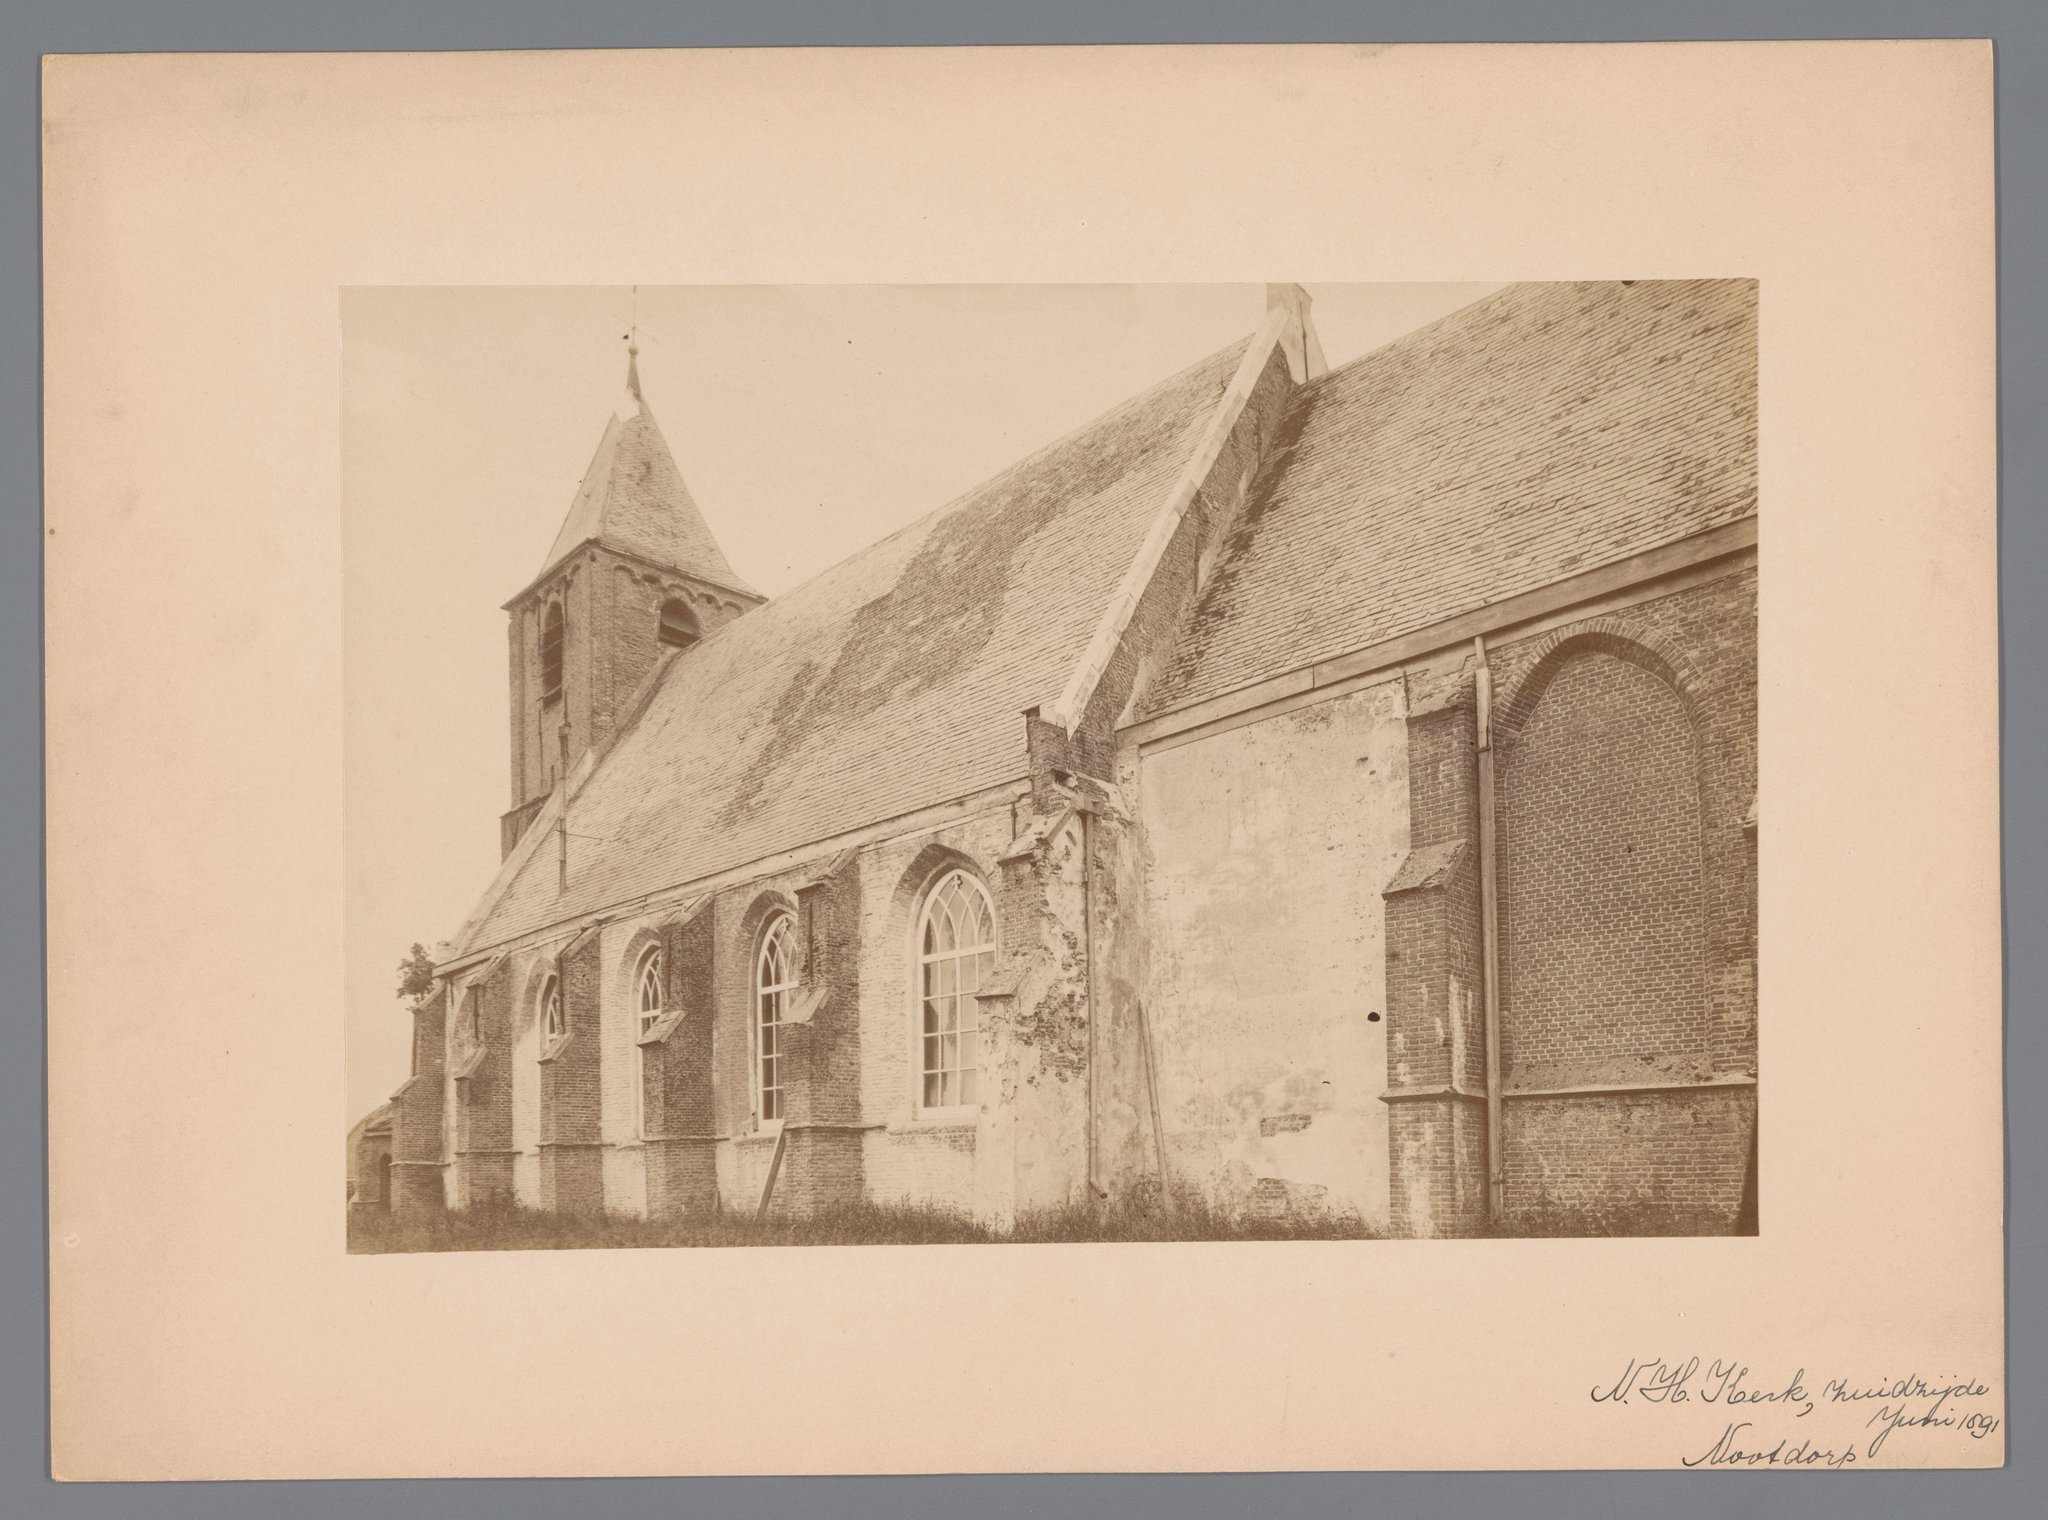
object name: photograph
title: Zuidzijde van de Dorpskerk van Nootdorp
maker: anoniem (monumentenzorg)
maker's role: fotograaf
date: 1891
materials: cardboard, photographic support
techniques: albumen print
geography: nootdorp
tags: church (exterior)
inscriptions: annotation: ‘N.H. Kerk, zuidzijde/ juni 1891/ Nootdorp’, annotation: ‘Kerk v/d N.H. gemeente te Nootdorp/ noordzijde/ juni 1891’